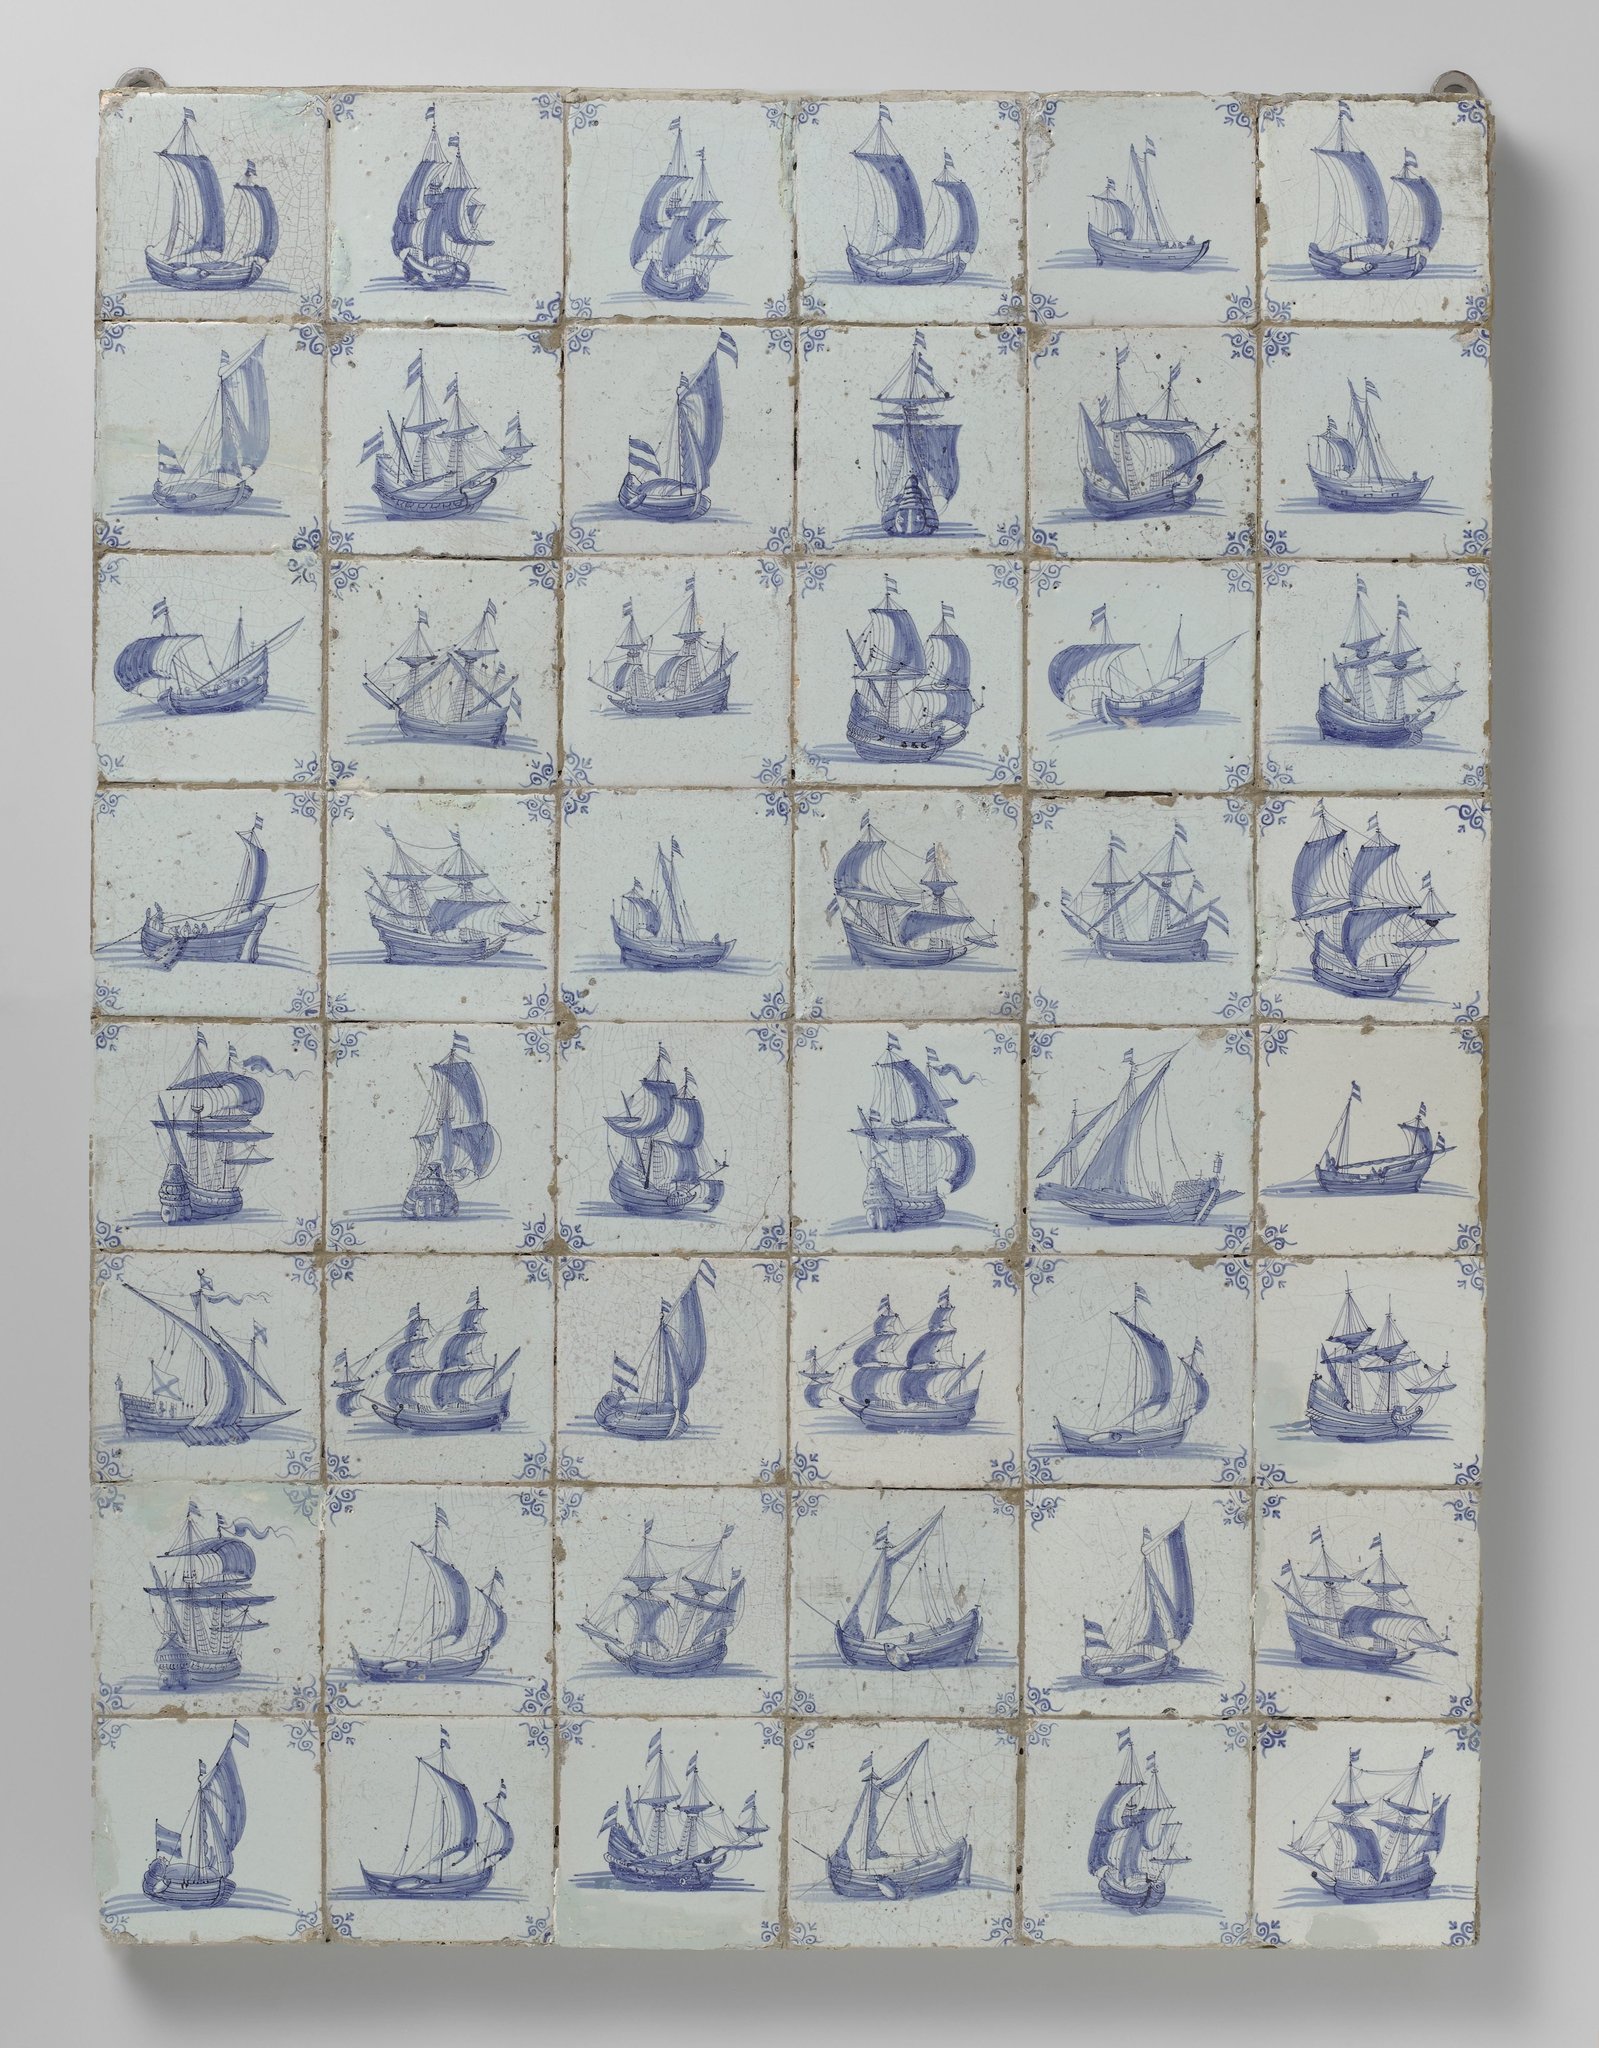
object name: tile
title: Veld van achtenveertig tegels met schepen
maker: Anonymous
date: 1650-1680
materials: earthenware, glaze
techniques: maiolica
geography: netherlands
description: Veld van achtenveertig tegels (8 x 6) elk met een blauw en paars geschilderd schip. In de hoeken, een ossenkop.